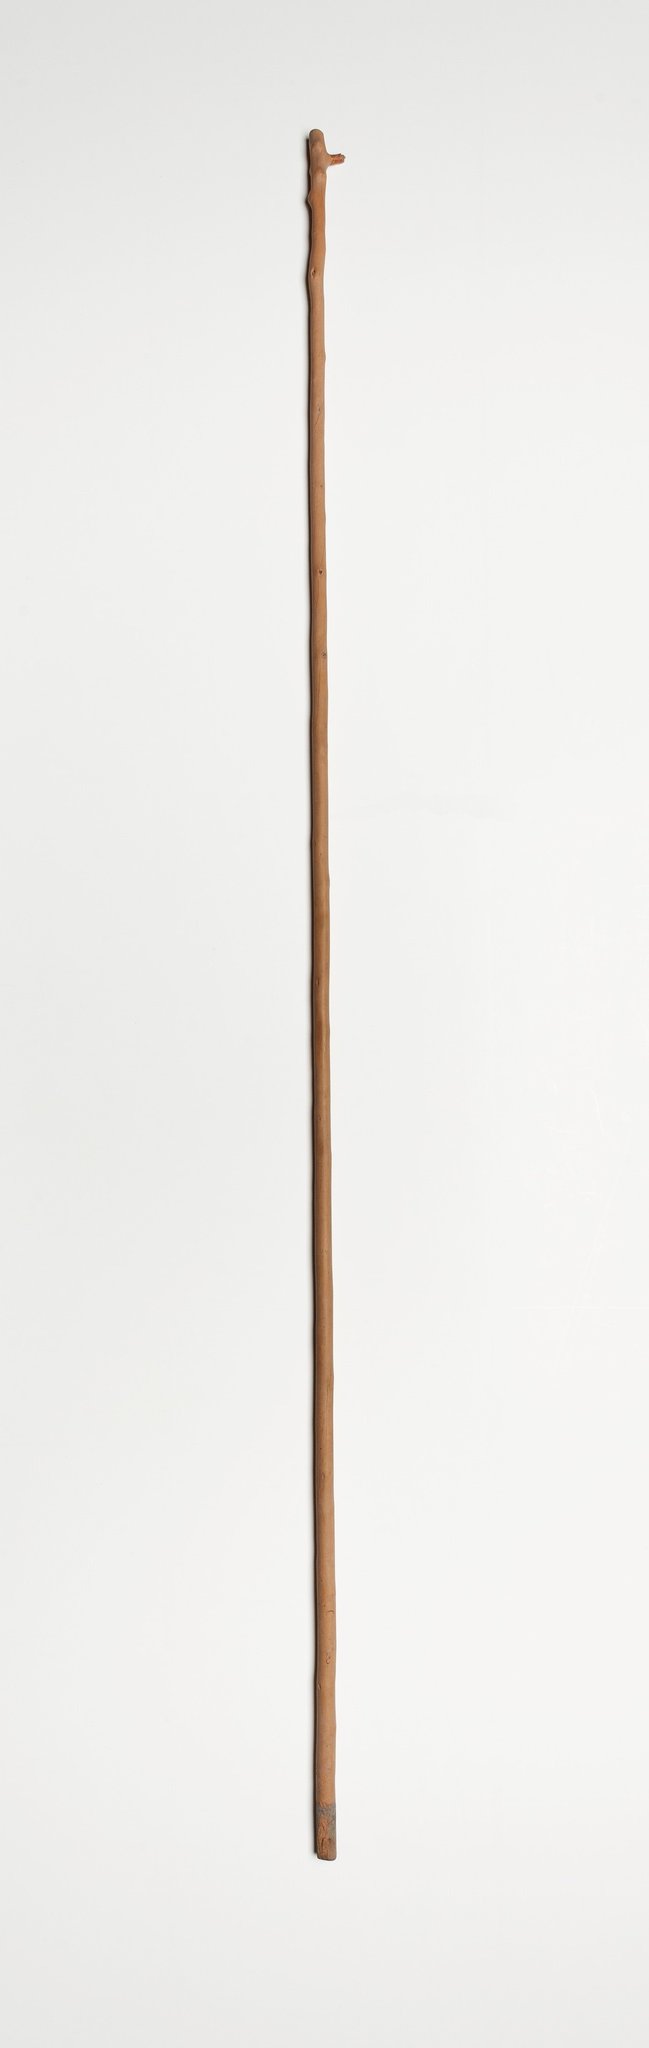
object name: staff, forked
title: Forked Staff of Harmose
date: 1479-1458 BCE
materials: wood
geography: egypt